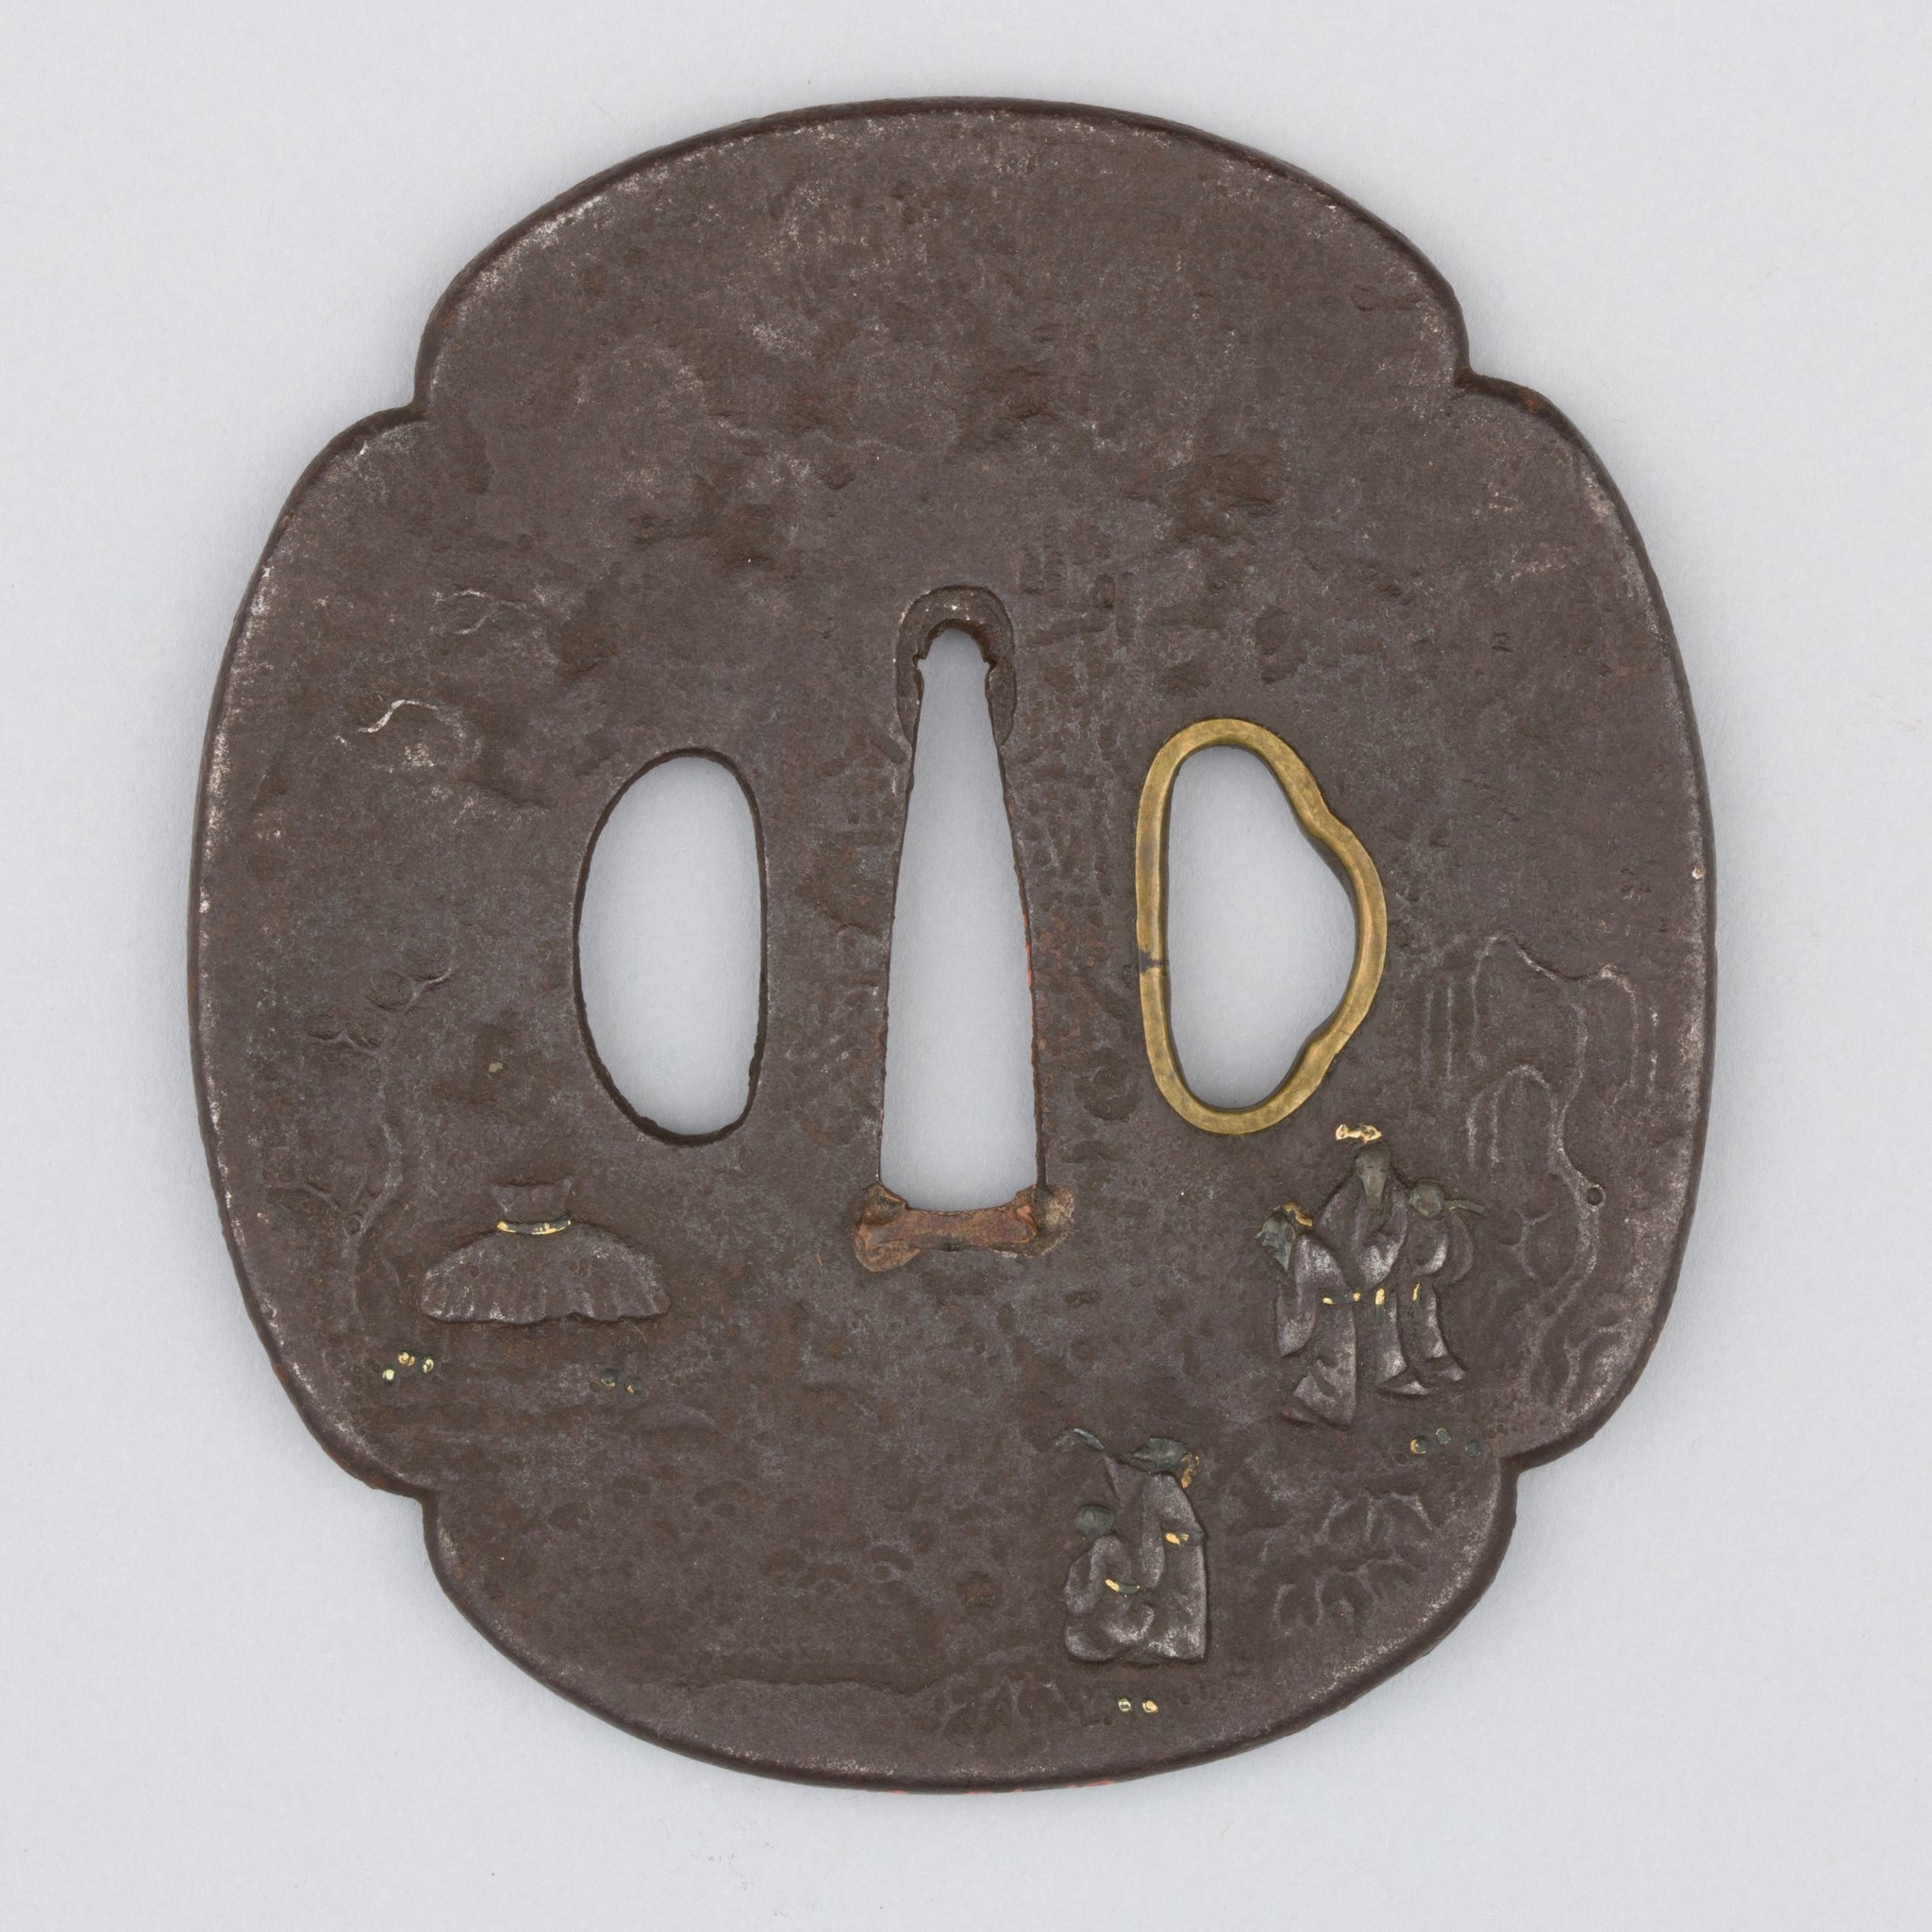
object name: sword guard tsuba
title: Sword Guard (Tsuba)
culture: japanese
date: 1667-1700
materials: copper, iron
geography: japan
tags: men